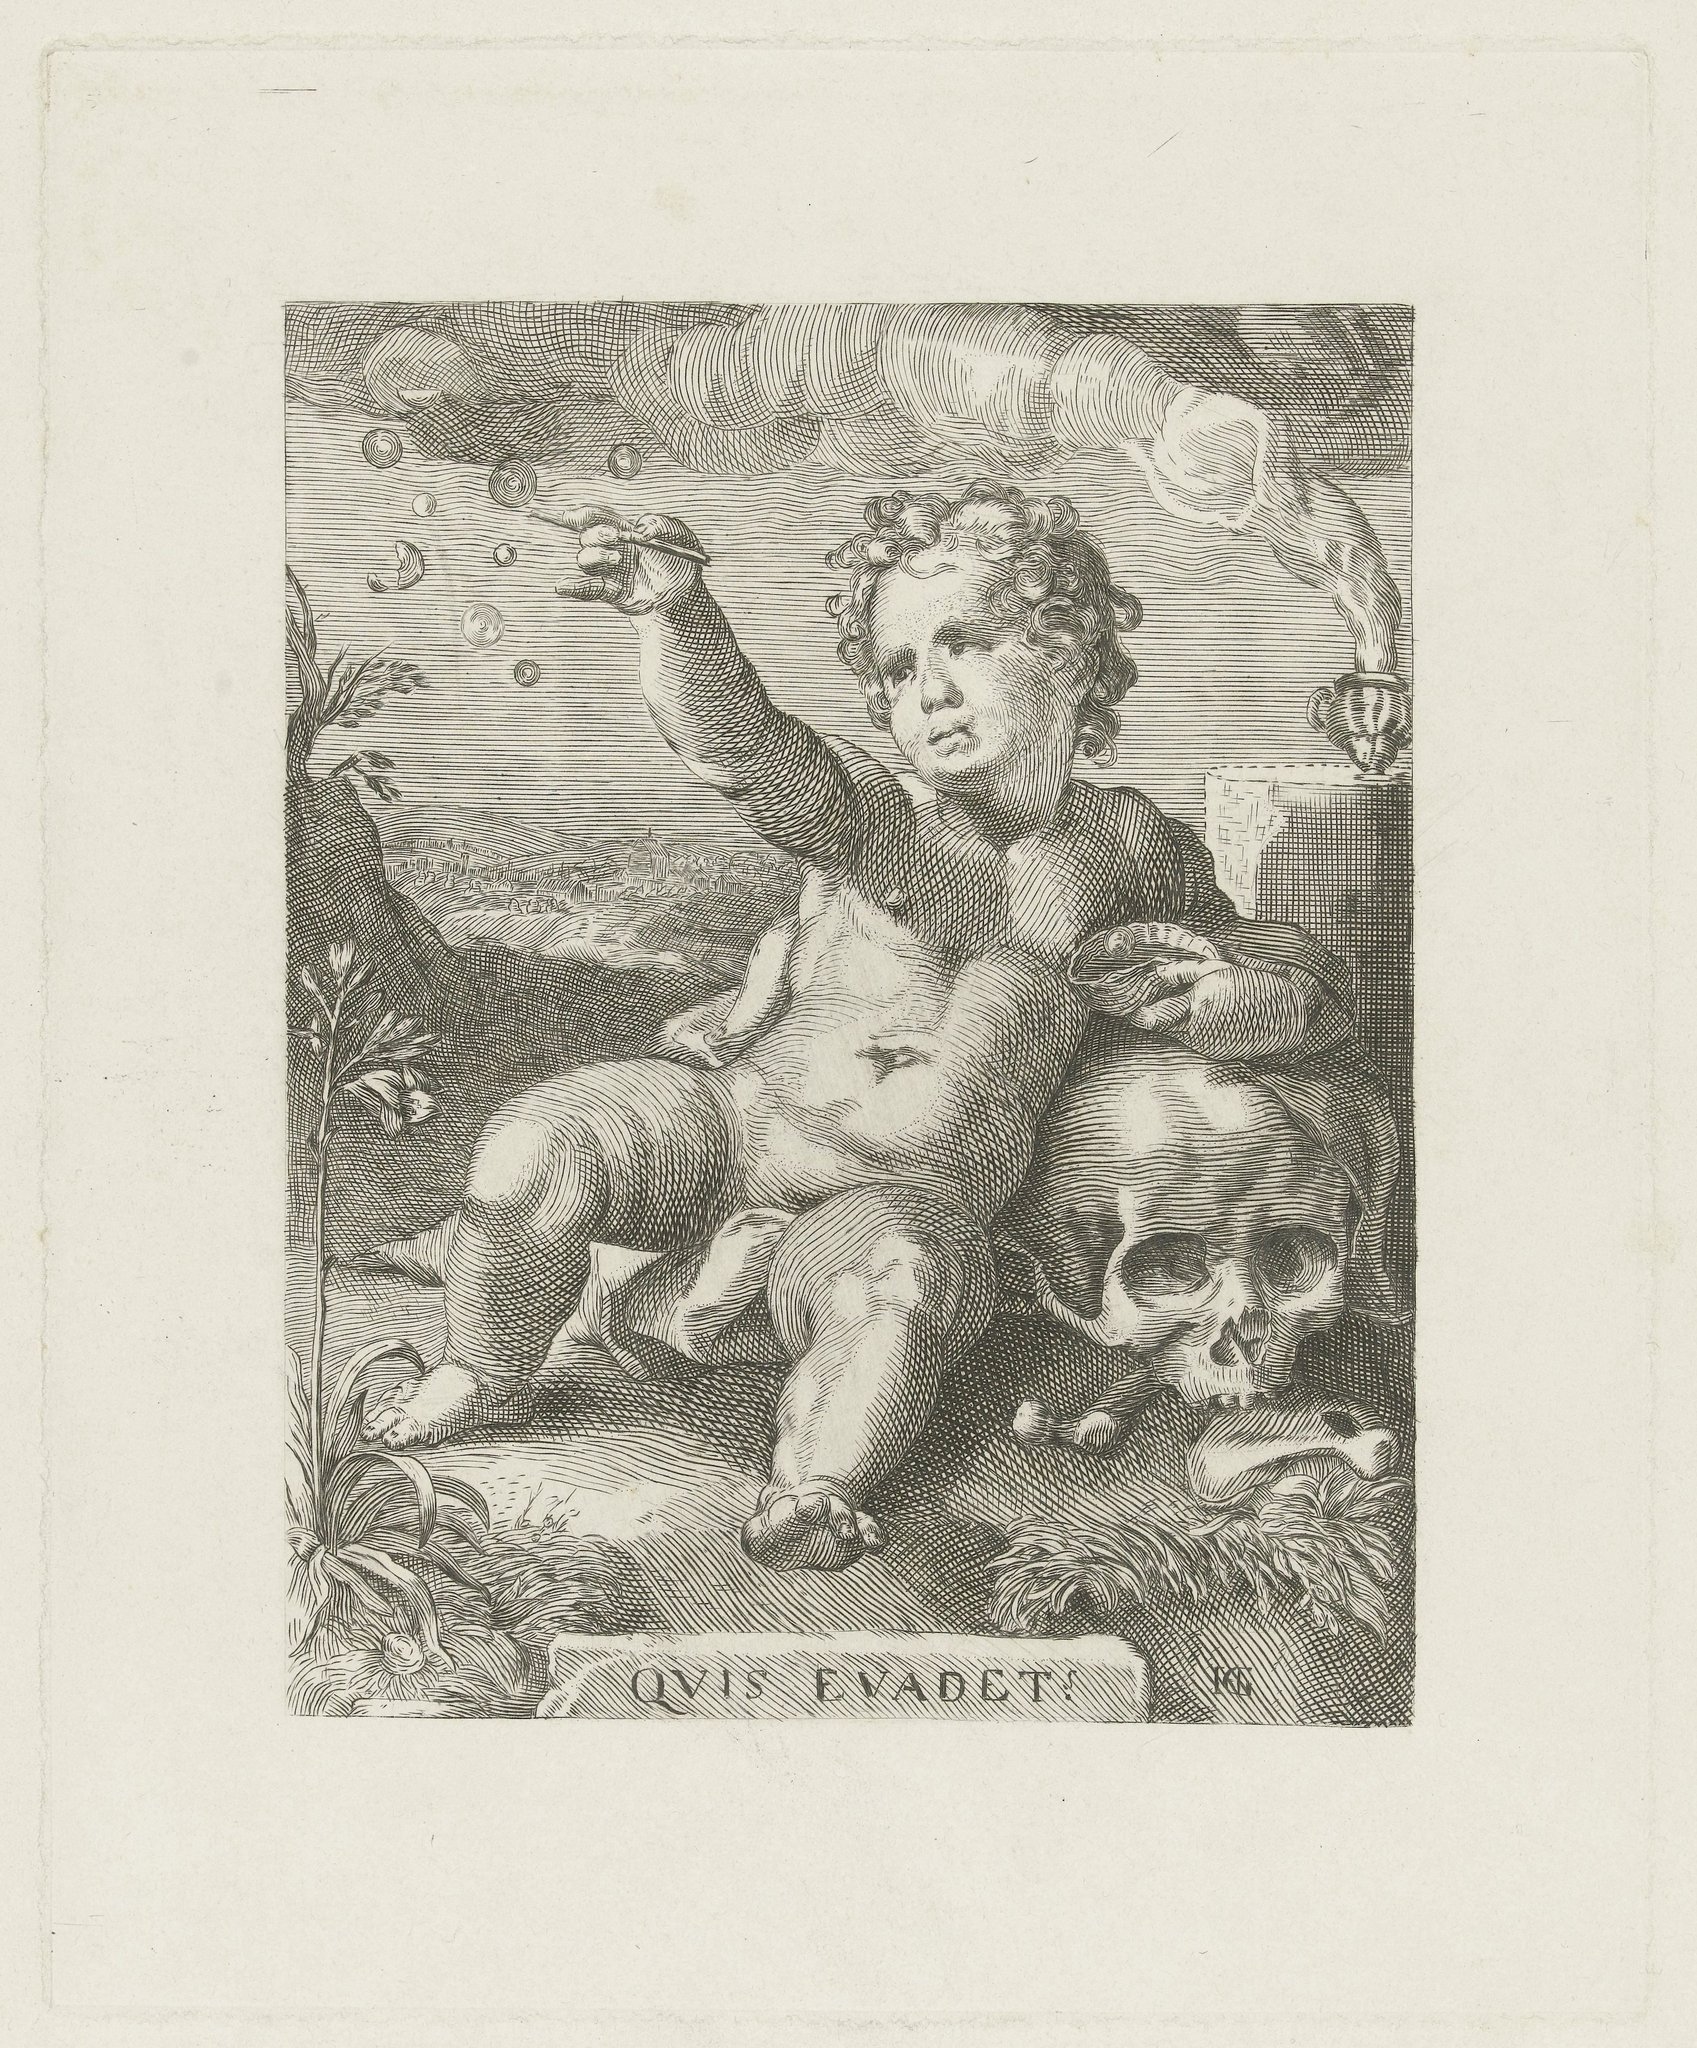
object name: print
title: Allegory of Transience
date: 1861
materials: paper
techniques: engraving, etching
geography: netherlands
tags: (children or putti) blowing bubbles, 'homo bulla' ~ scene symbolizing 'vanitas'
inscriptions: inscription: ‘A Dickhoff 20 sep 1861’, collector's mark: Lugt 2228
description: Een putto zit op de grond en leunt tegen een schedel, terwijl hij in zijn rechterhand een pijpje houdt waarmee hij bellen heeft geblazen. In zijn linkerhand houdt hij een schelp. Achter hem wierrookvat waaruit rook opstijgt.